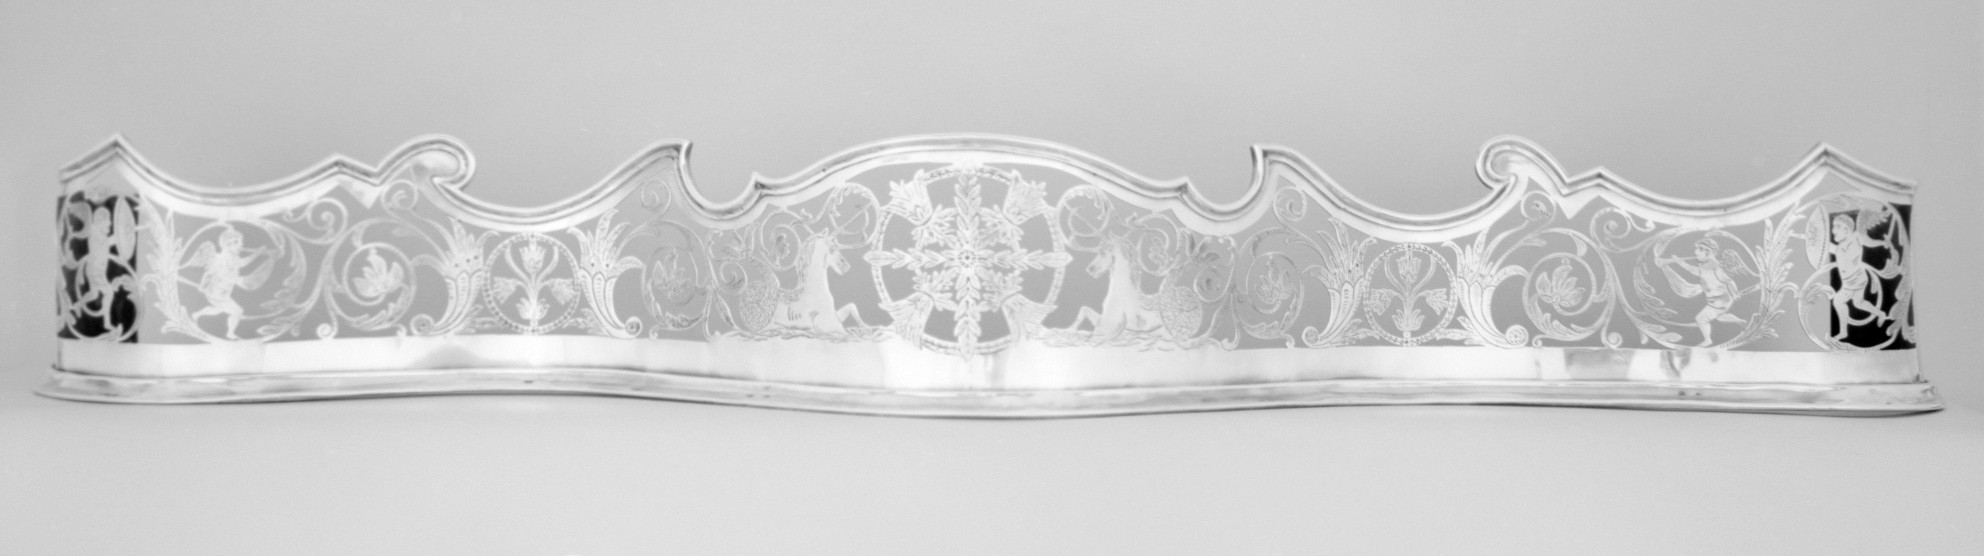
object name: fireplace fender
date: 1751-1775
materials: brass